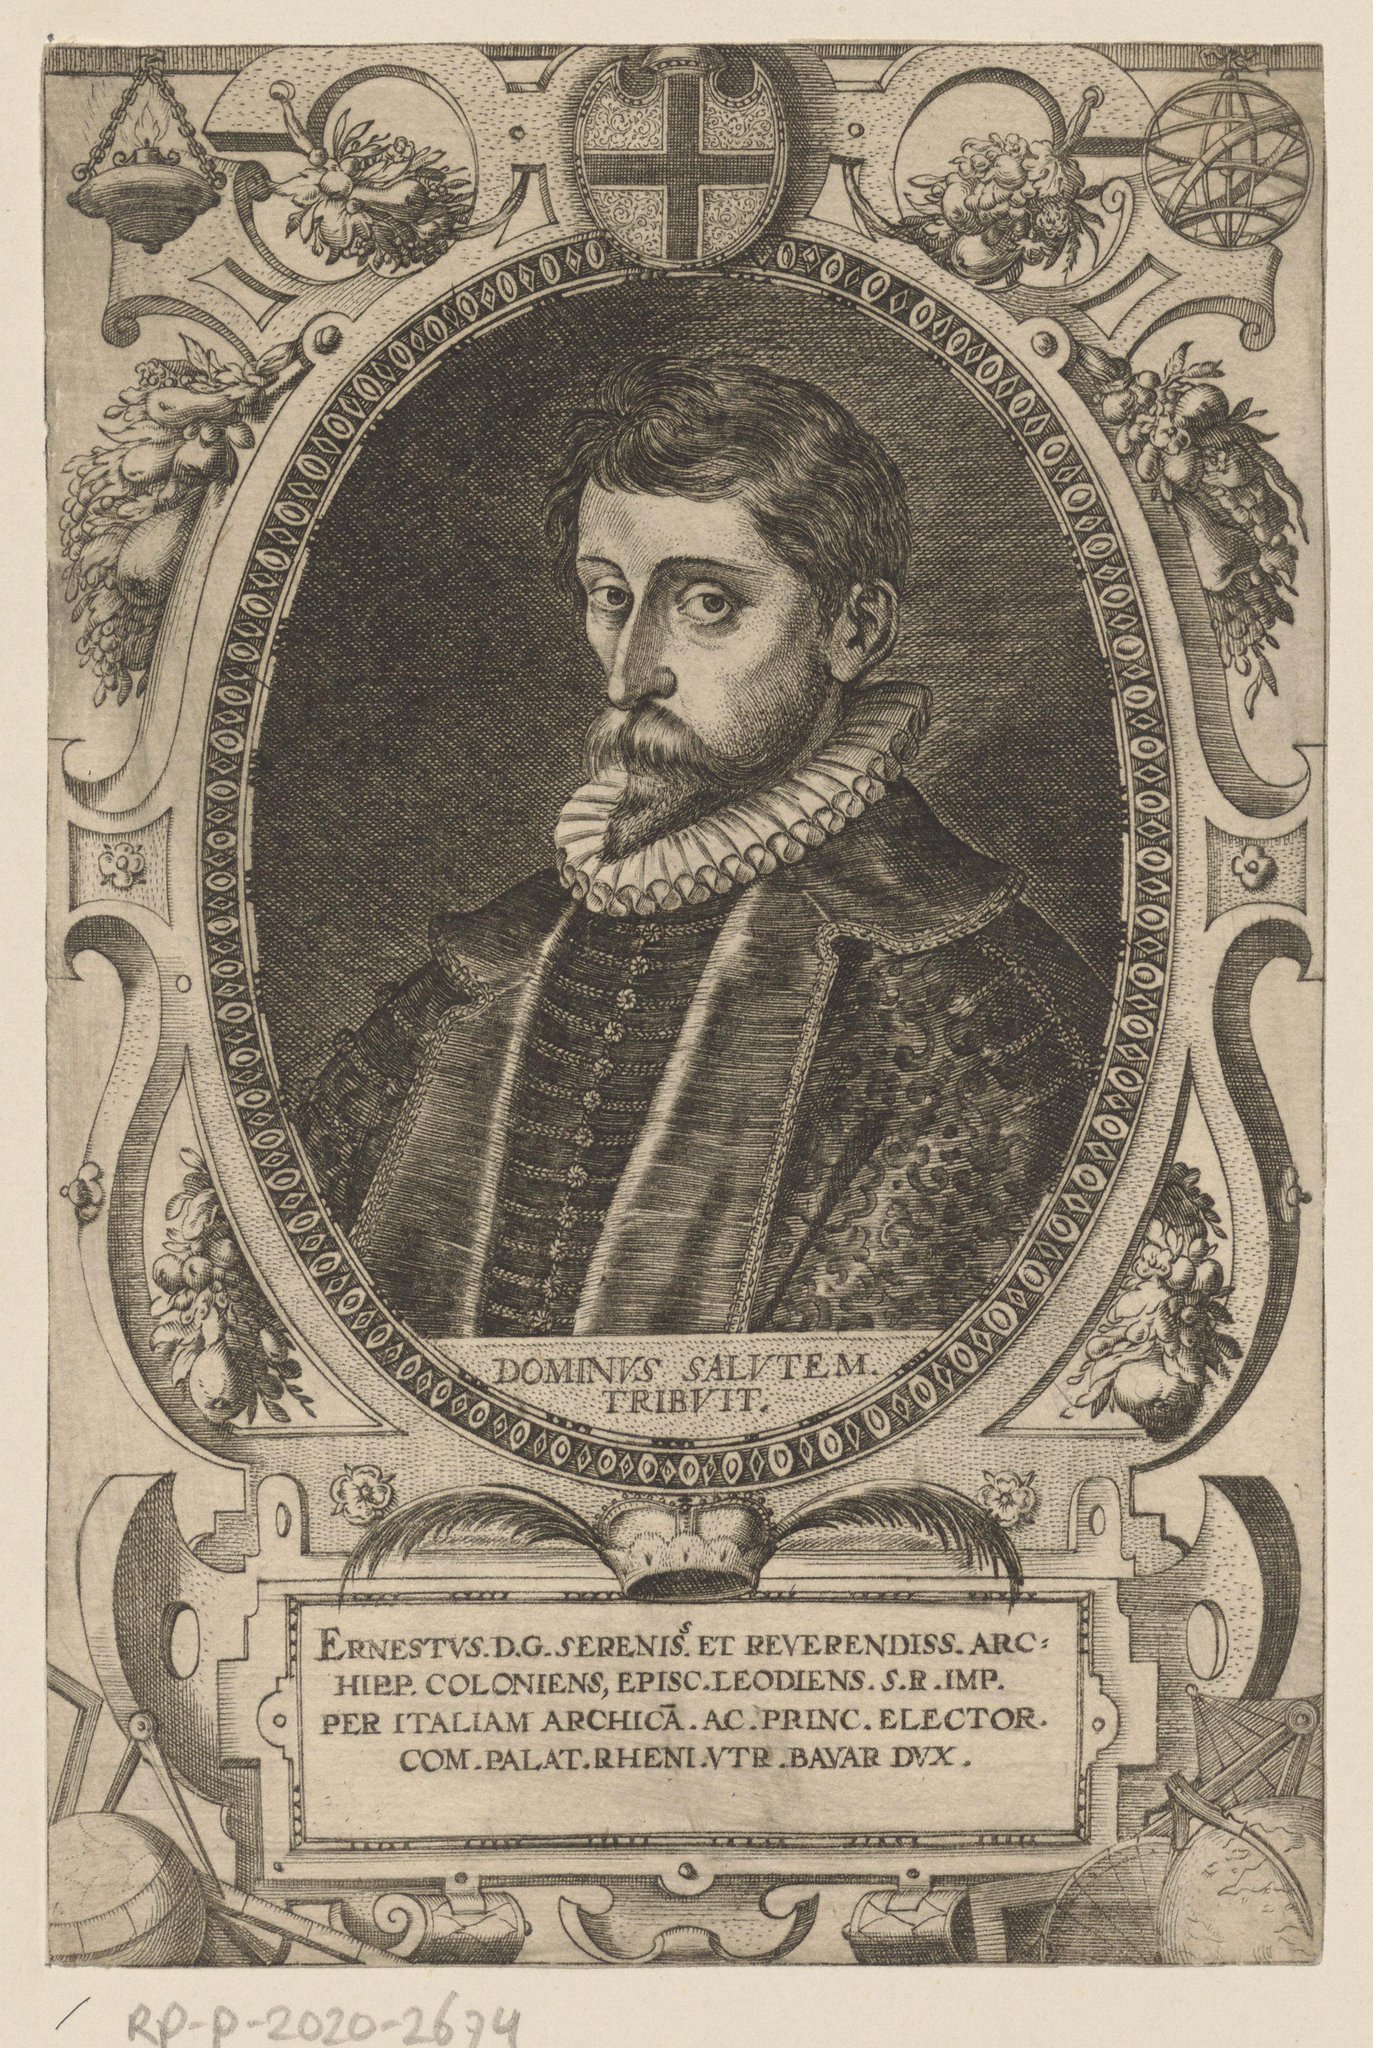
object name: print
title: Atrium Heroicum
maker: dominicus custos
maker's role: print maker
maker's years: 1560-1615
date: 1600-1604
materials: paper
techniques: engraving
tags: ernst van beieren (prins-bisschop van luik), fruits and vegetables ~ ornament, historical persons, compasses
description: De serie werd tussen 1600 en 1604 in vier delen uitgegeven.